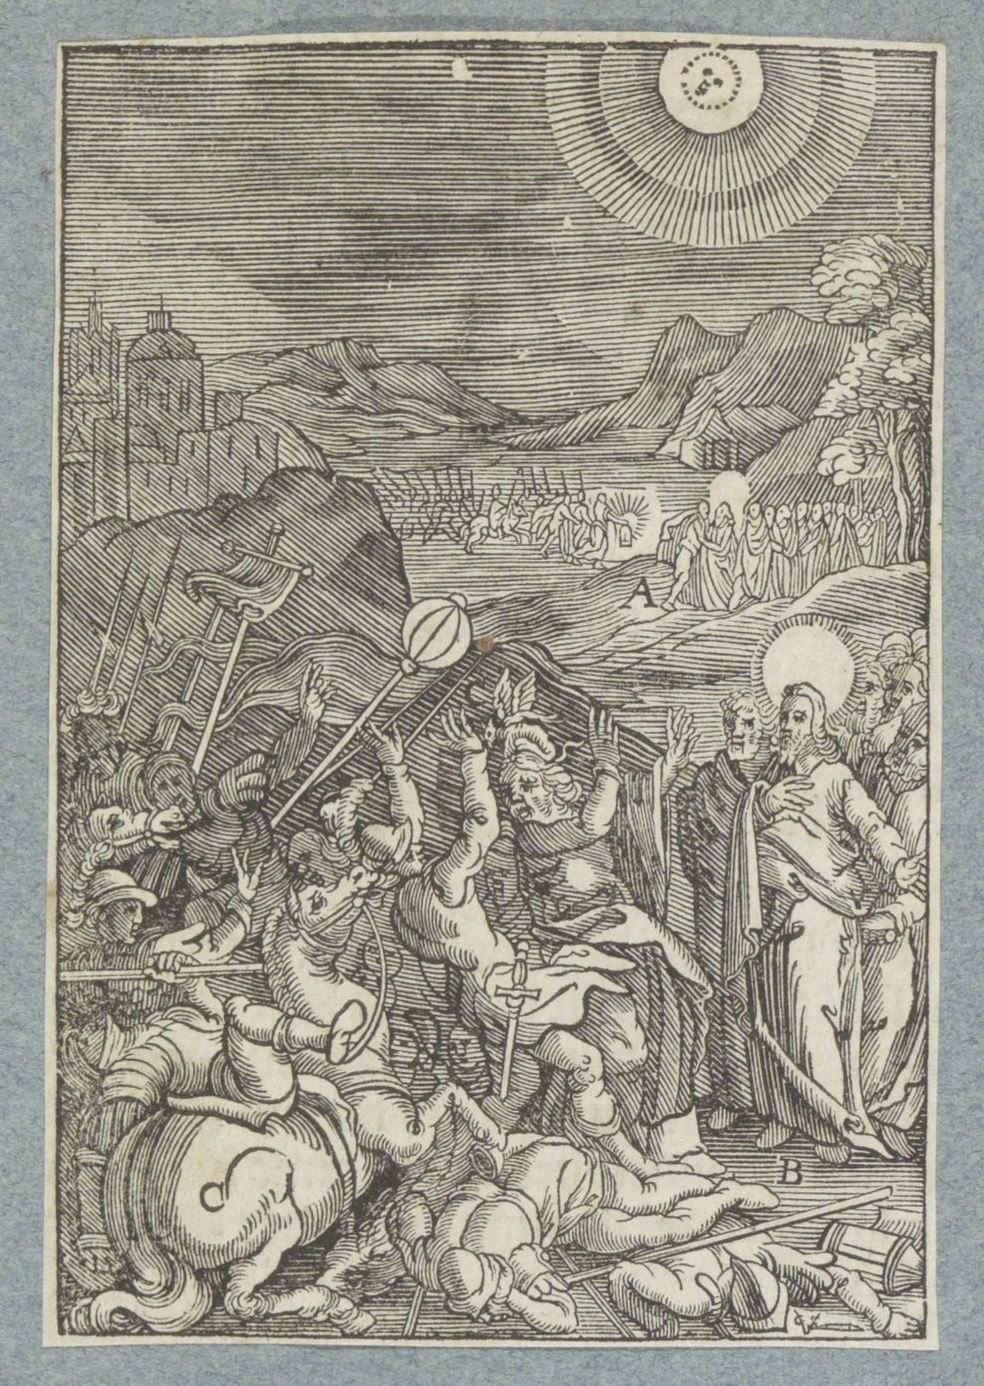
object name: album leaf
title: Verraad van Judas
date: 1629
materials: paper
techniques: letterpress printing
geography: antwerp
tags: christ's prayer in the garden of gethsemane during the night, christ makes himself known; the soldiers fall to the ground ~ the kiss of judas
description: De prent is afkomstig uit een van de uitgaven van P.J. Paets uit Amsterdam. De prent wordt voor het eerst gebruikt in: Der Zielen Lust-hof. Leuven, I.Jacbosz voor P.J. Paets [= Amsterdam, P.J. Paets], 1629. De voorstelling is gekopieerd naar een prent van Hieronymus Wierix voor: Nadal, Jerónimo. Evangelicae Historiae Imagines. Antwerpen, M. Nutius, 1593.